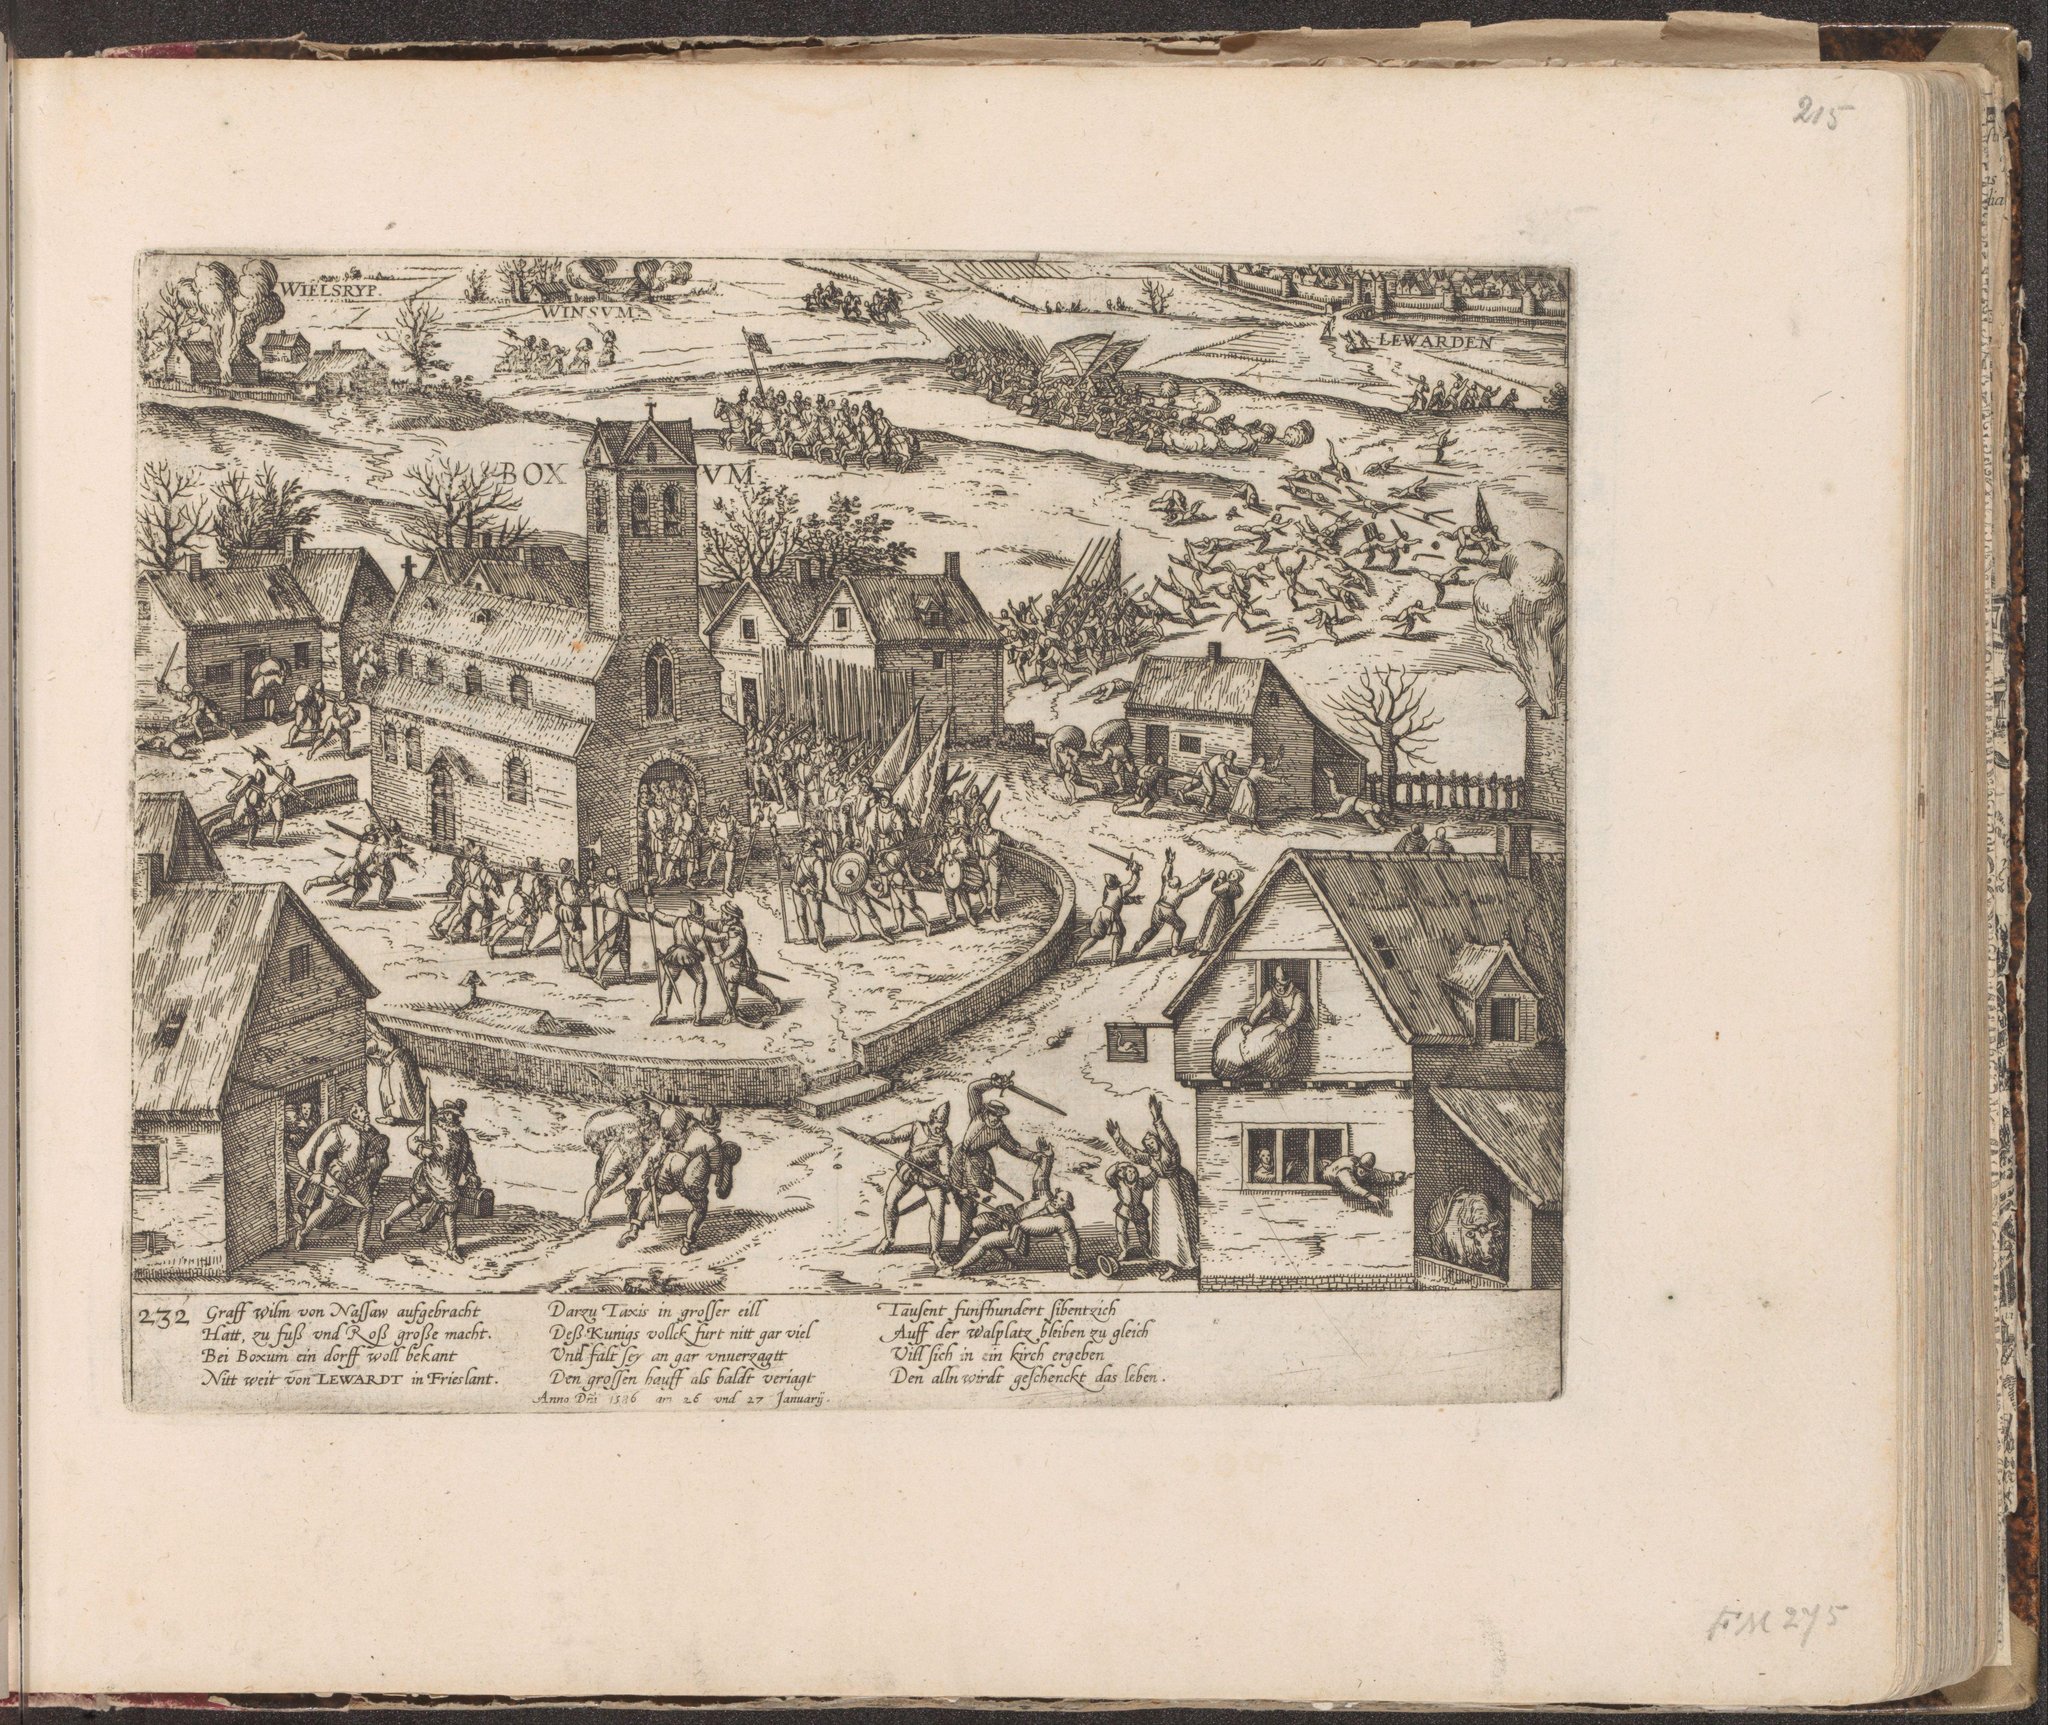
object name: history print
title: Serie 9: Nederlandse en Duitse Gebeurtenissen, 1583-1587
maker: frans hogenberg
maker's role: print maker, publisher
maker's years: 1538-1590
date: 1587-1591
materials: paper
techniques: etching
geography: cologne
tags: battle, fighting in general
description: Slag bij Boksum in Friesland, 26-27 januari 1586. Het Staatse leger onder Willem van Nassau door de Spanjaarden verslagen. Gevechten in het open veld en soldaten bij de kerk in Boksum, in de verte Leeuwarden, Winsum en Wielsryp. Met onderschrift van 12 regels in het Duits. Linksonder genummerd: 232. De prent maakt deel uit van een album.